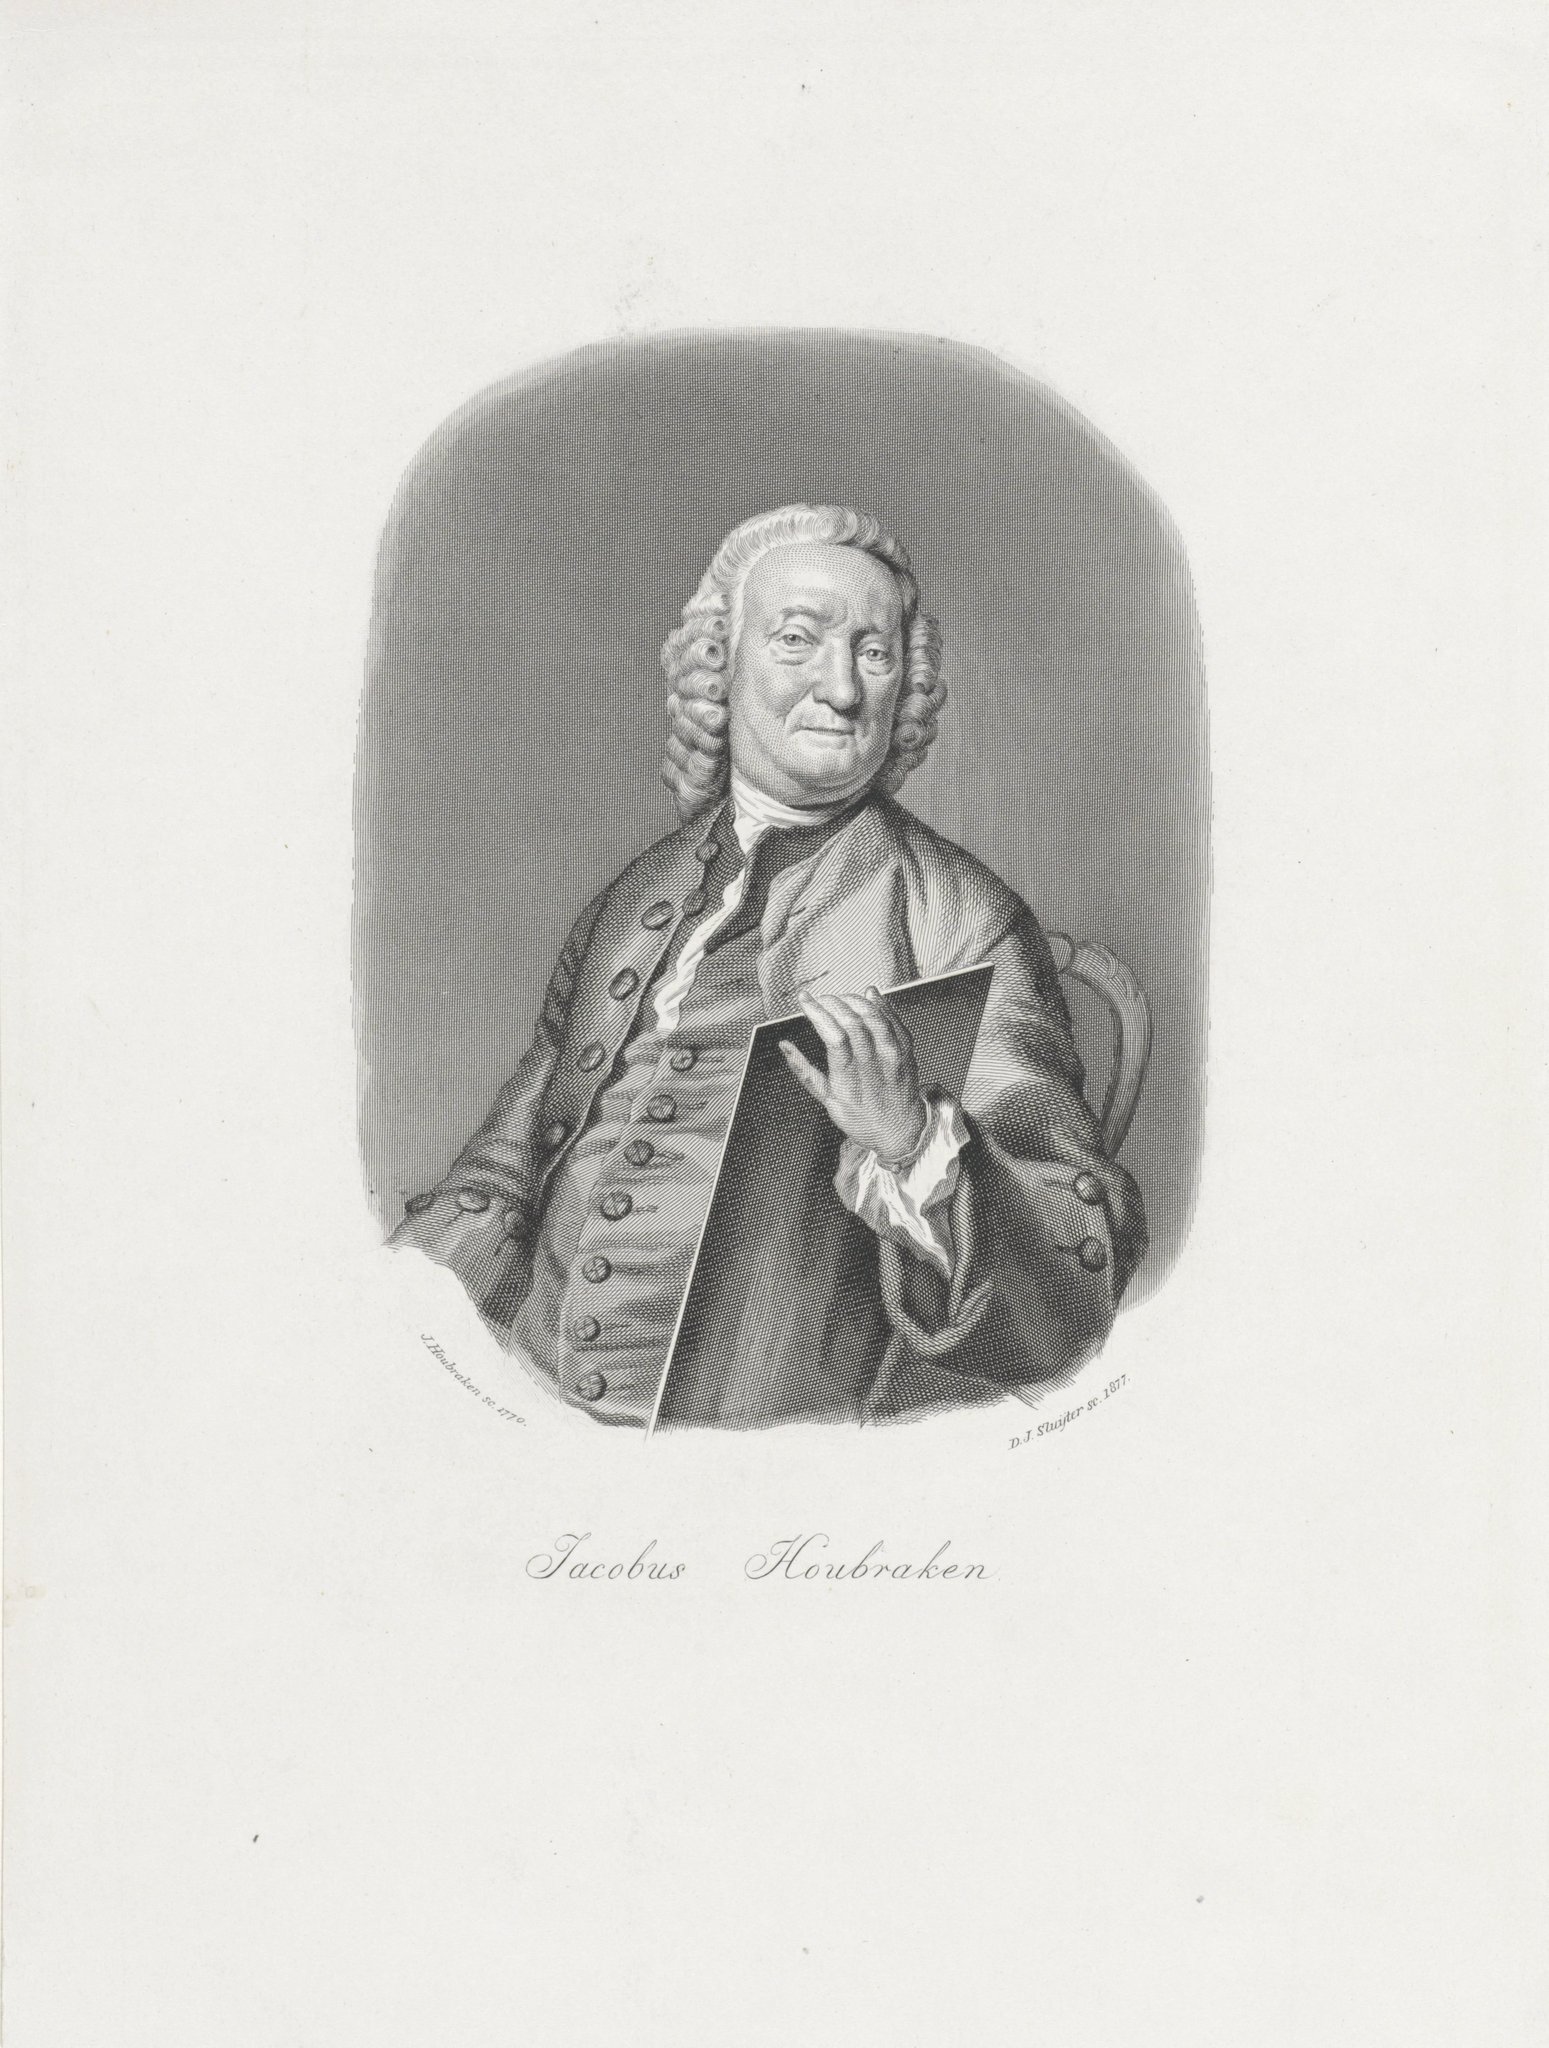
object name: print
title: Portret van Jacob Houbraken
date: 1877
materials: paper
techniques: etching, engraving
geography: amsterdam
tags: dordrecht, amsterdam, print maker, draughtsman, jacob houbraken, portrait, self-portrait of artist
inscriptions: collector's mark: Lugt 2228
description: Portret van de prentmaker en tekenaar Jacob Houbraken op 71-jarige leeftijd, zittend op een stoel. Hij houdt een plaat in de hand. Onder het portret zijn naam.